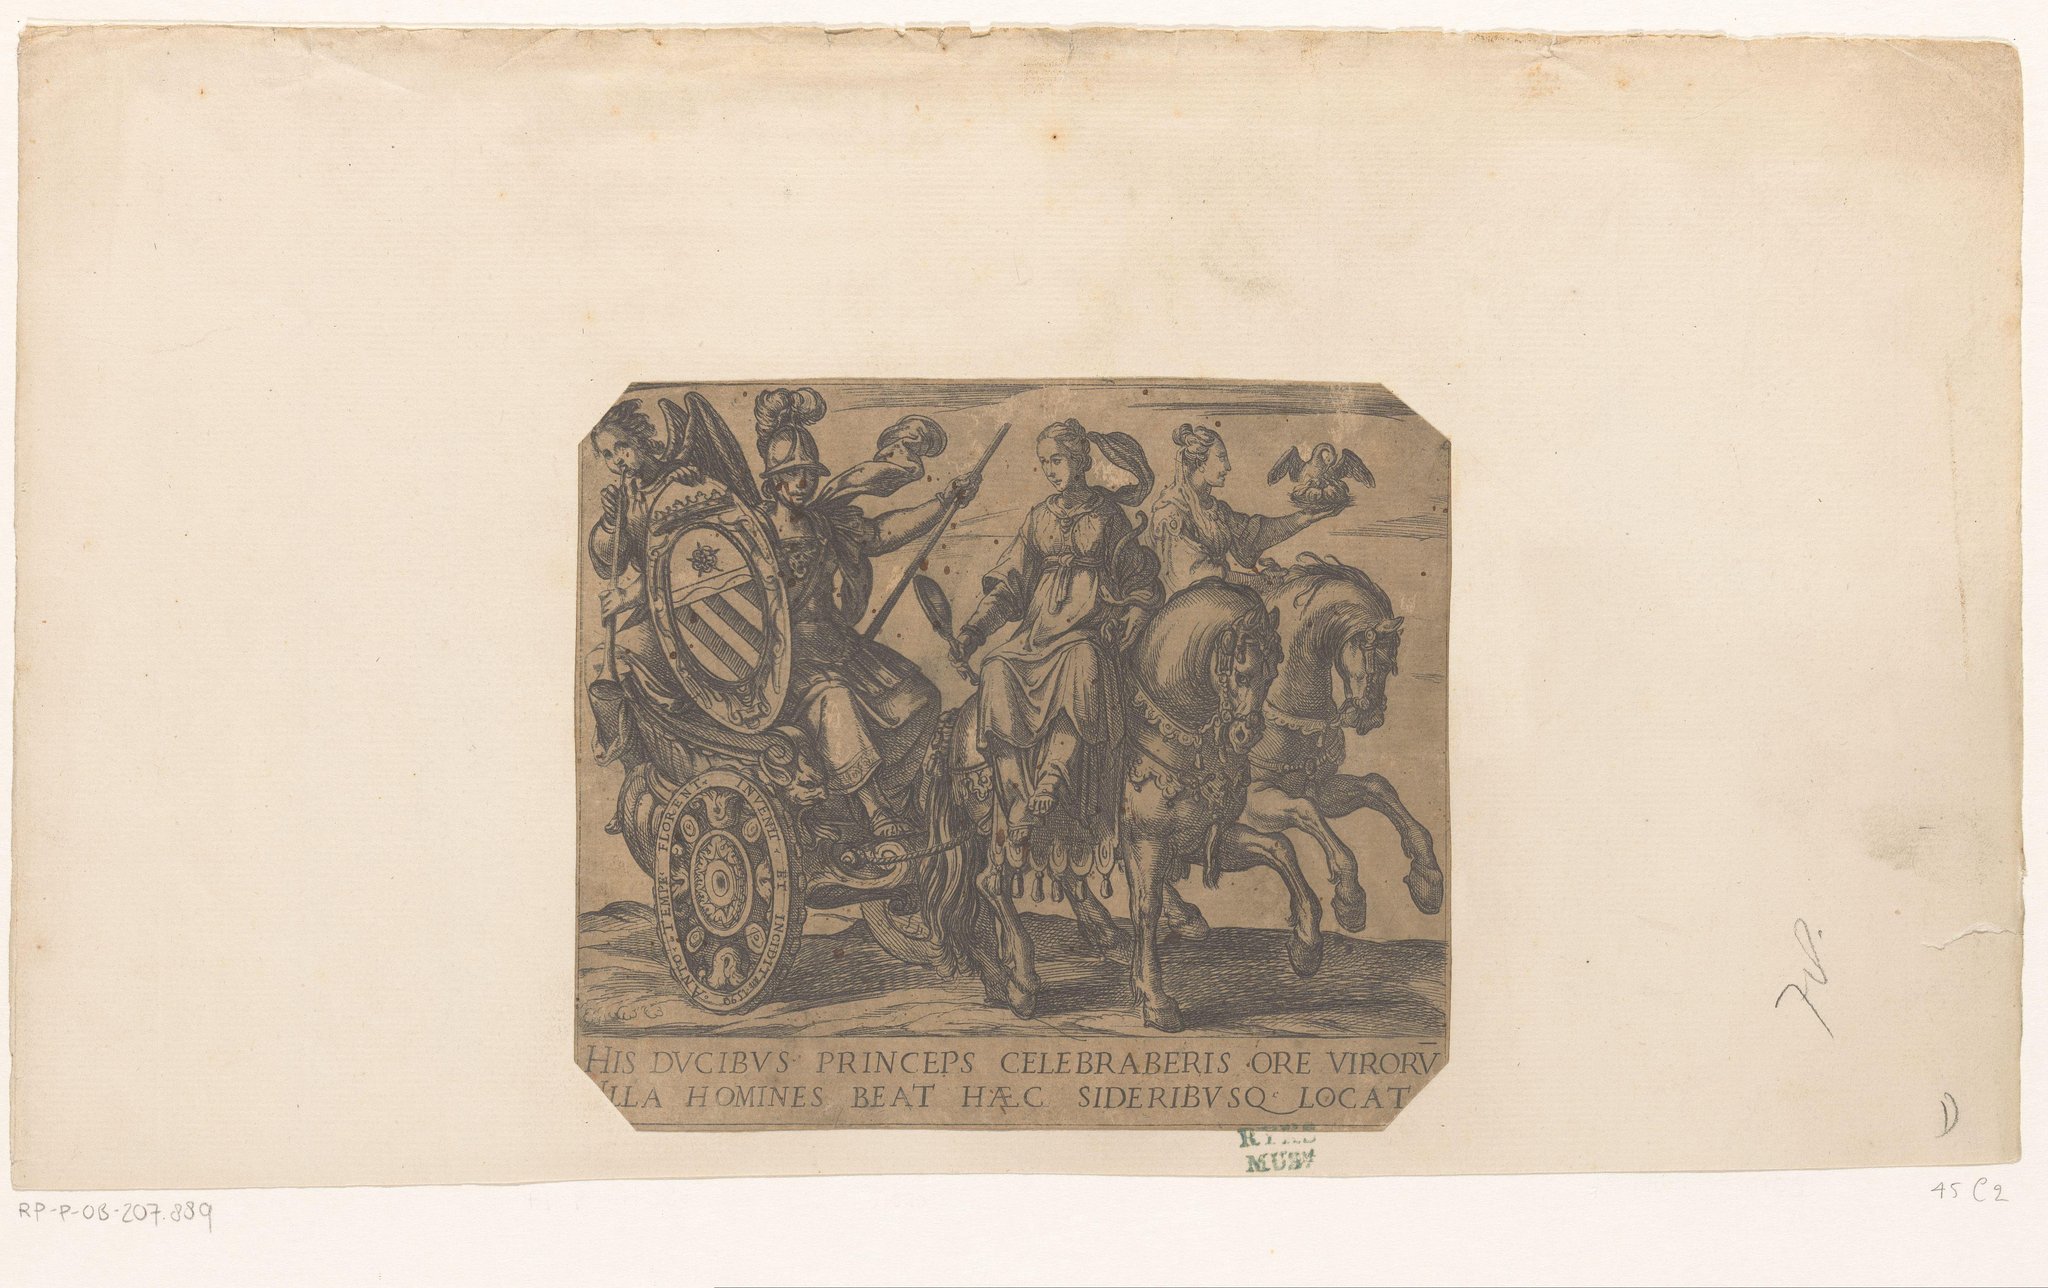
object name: titelprent, frontispice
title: Titelprent met Minerva op strijdwagen, geleid door Voorzichtigheid en Liefde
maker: antonio tempesta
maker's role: draughtsman, painter, print maker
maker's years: 1555-1630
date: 1590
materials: paper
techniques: etching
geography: italy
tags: (story of) minerva (pallas, athena), ancient forms of military vehicles: chariot, battle wagon, etc., love: 'frau minne' and other allegories, prudentia (prudence) as roman personification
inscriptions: collector's mark: Lugt 2165, collector's mark: Lugt 2228